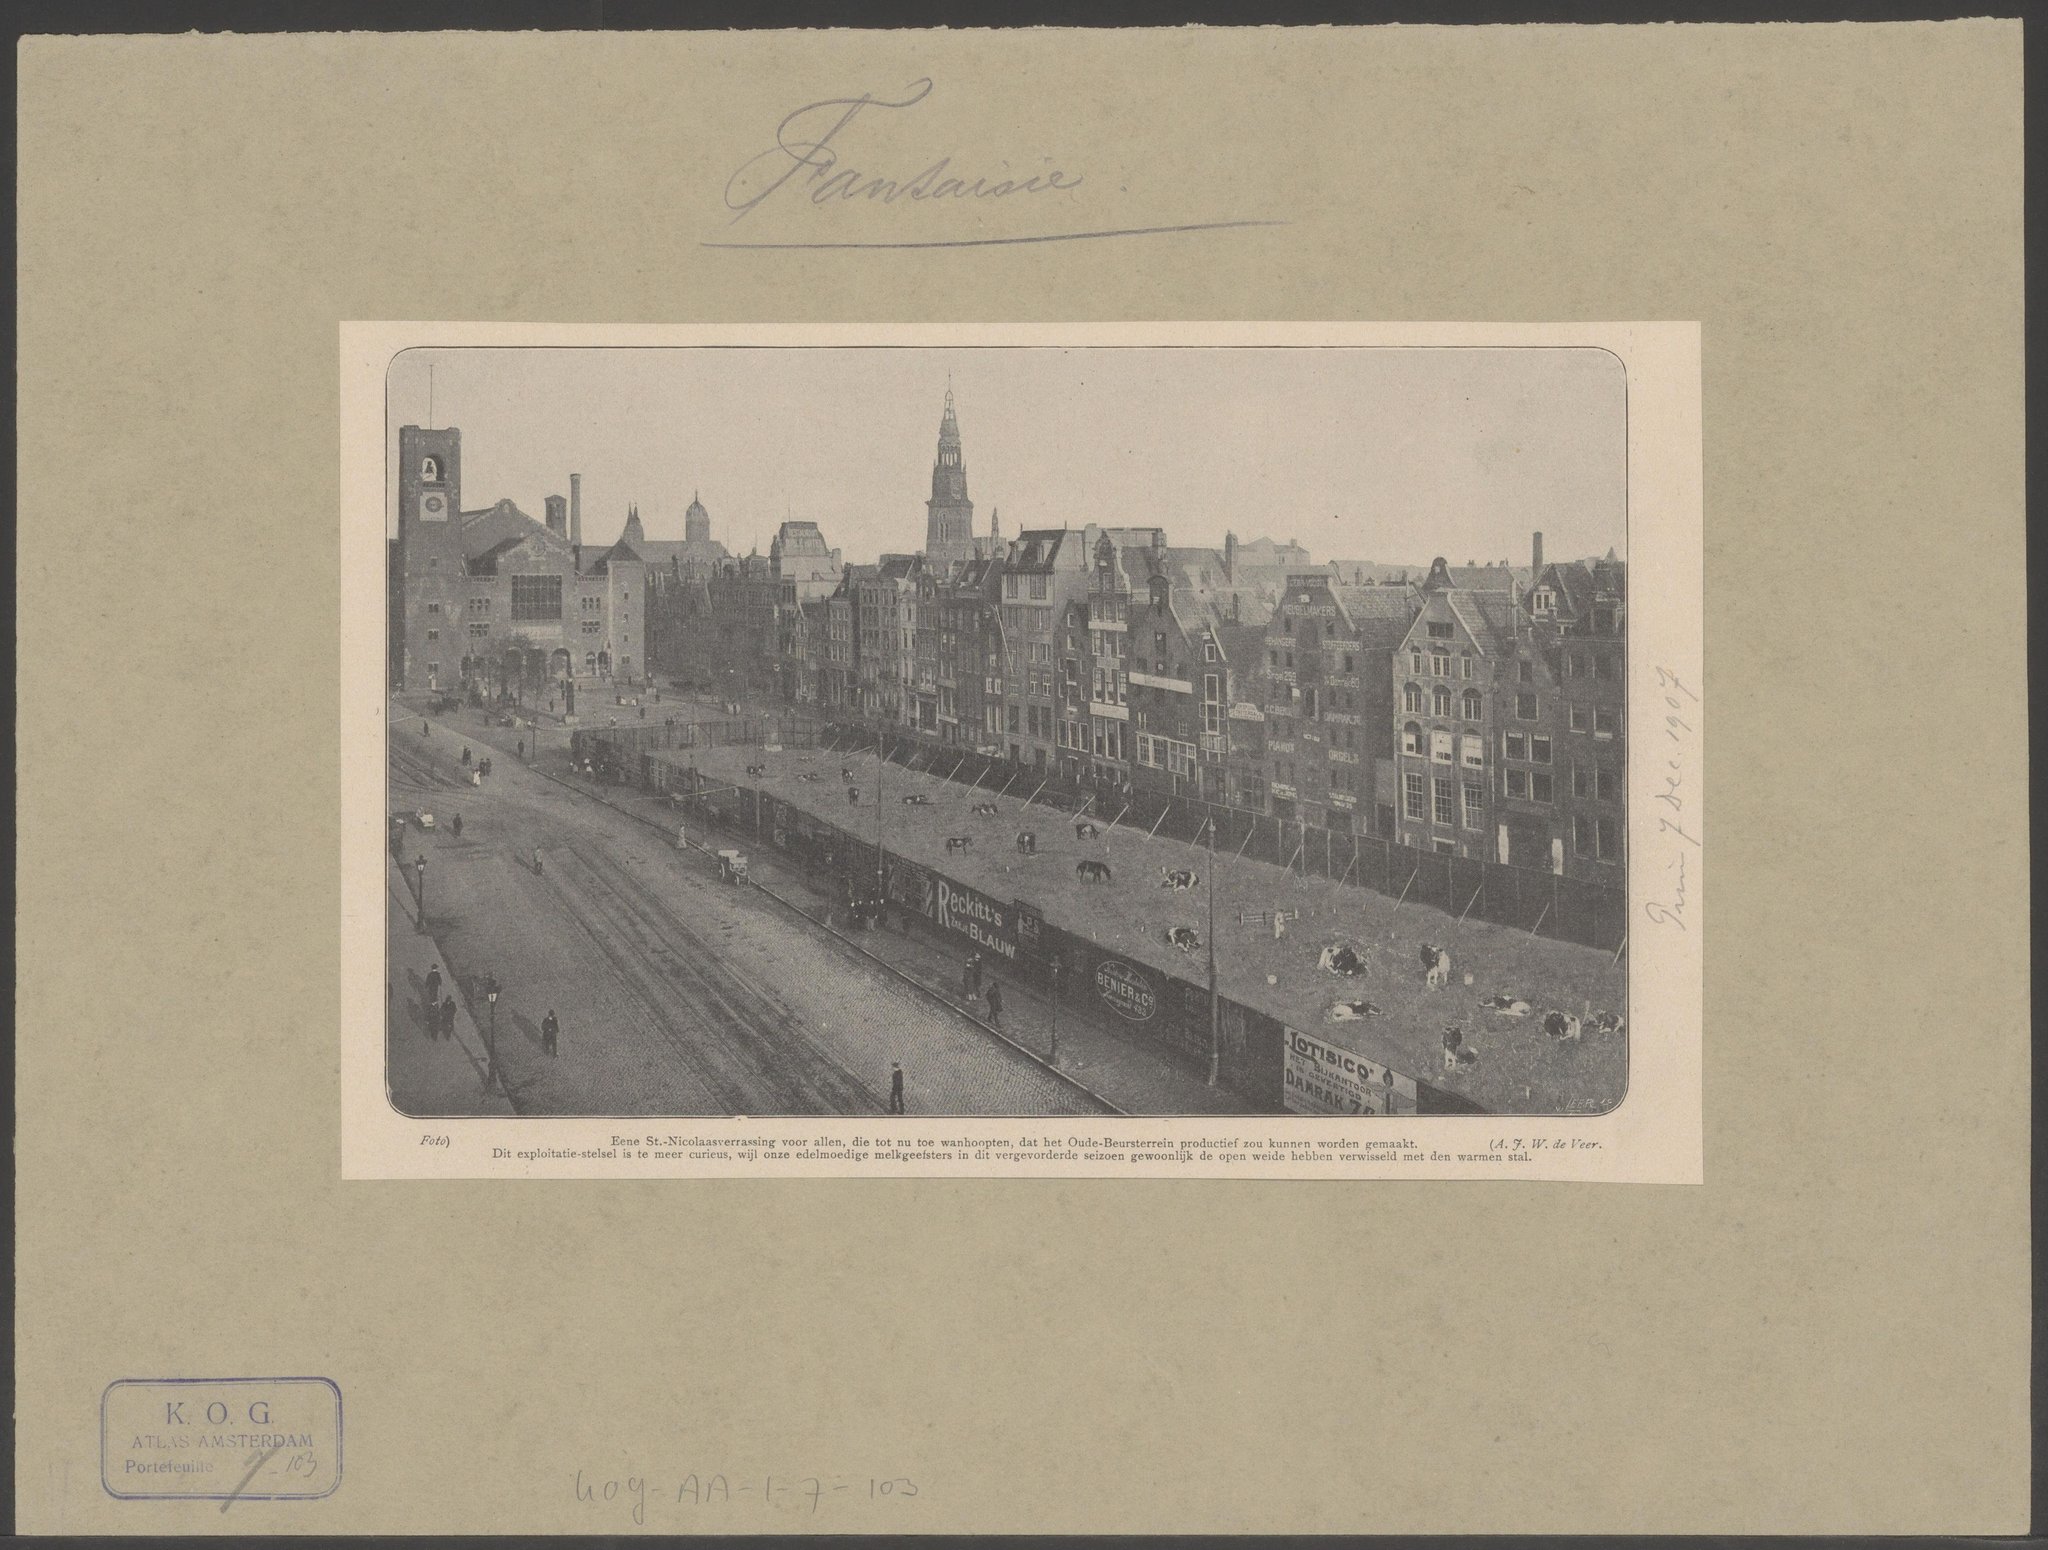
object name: photomechanical print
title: Gezicht op een grasveld met koeien op het Damrak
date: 1907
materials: paper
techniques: autotype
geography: amsterdam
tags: cow, city-view in general; 'veduta', street, market-hall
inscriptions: collector's mark: ‘7’ Lugt 1641b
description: Onderwerpsrubriek binnen de Atlas Amsterdam: Damrak, Damstraat, Doelensluis, Doelenstraat (Nieuwe), Driehoekstraat, Droogbak, Duvelshoek, Dijkstraat en Korte -.